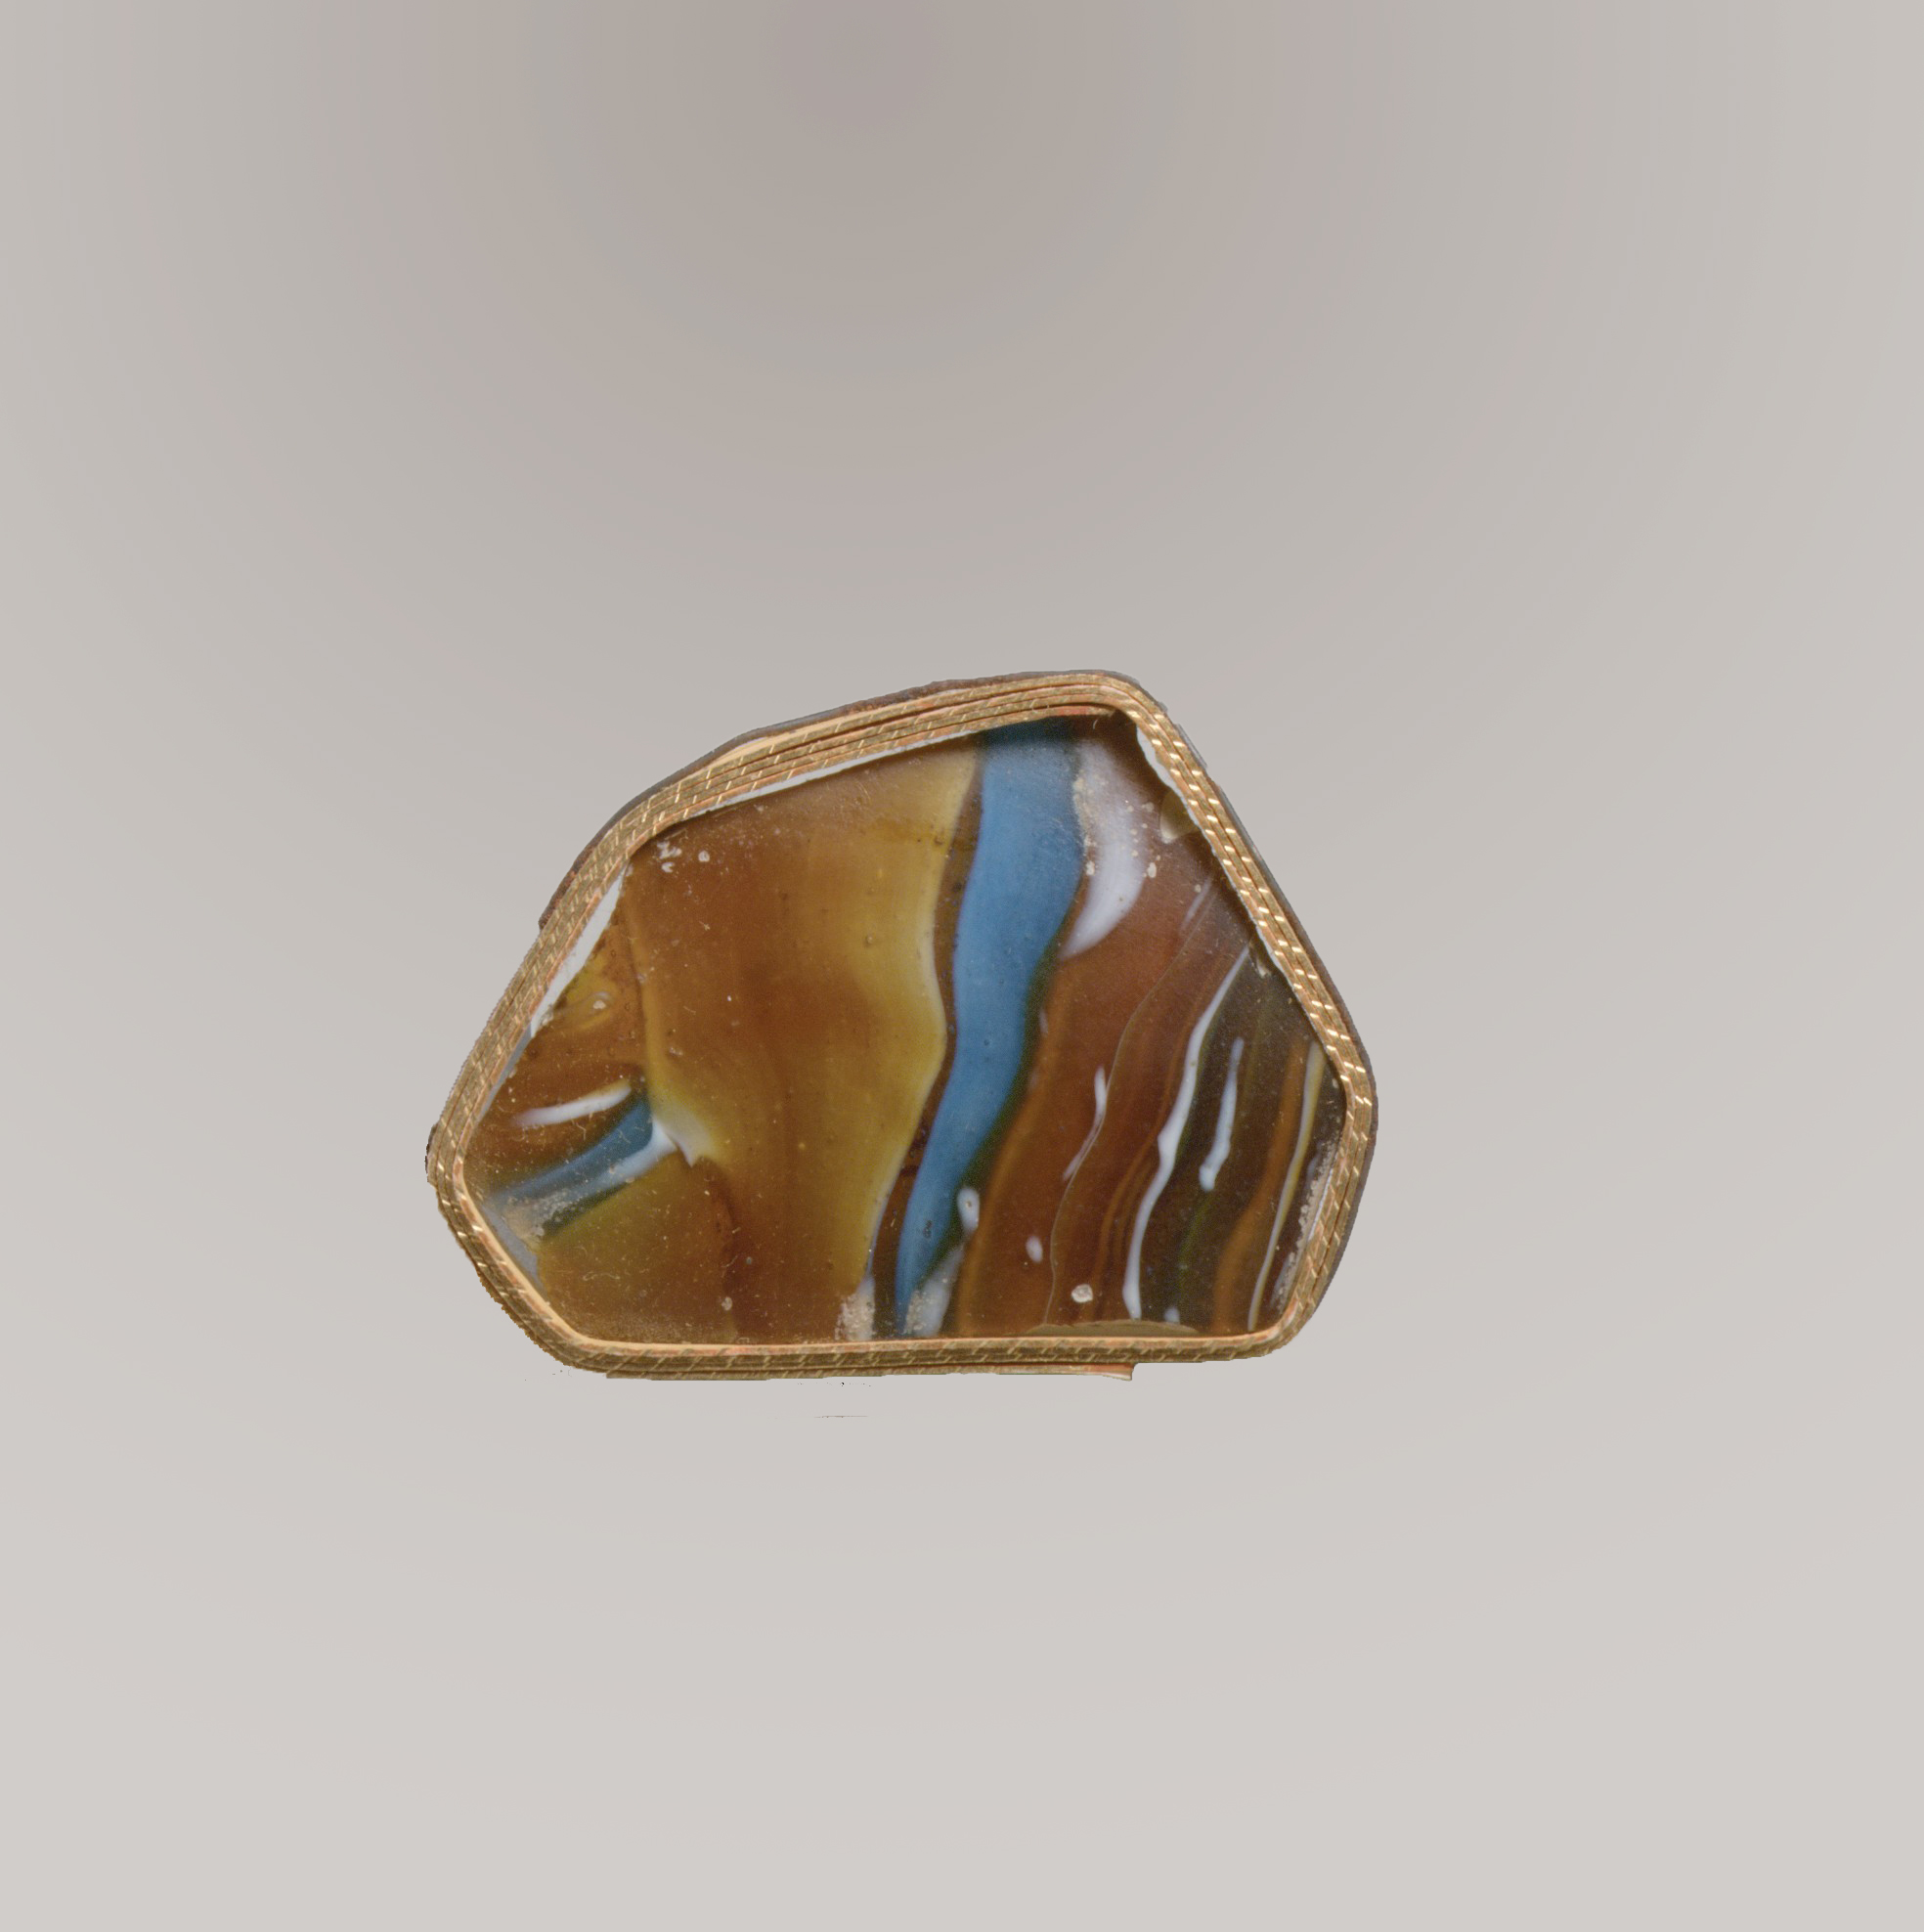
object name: fragment, mosaic glass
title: Glass mosaic bowl fragment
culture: roman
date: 34 BCE-33 CE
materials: glass